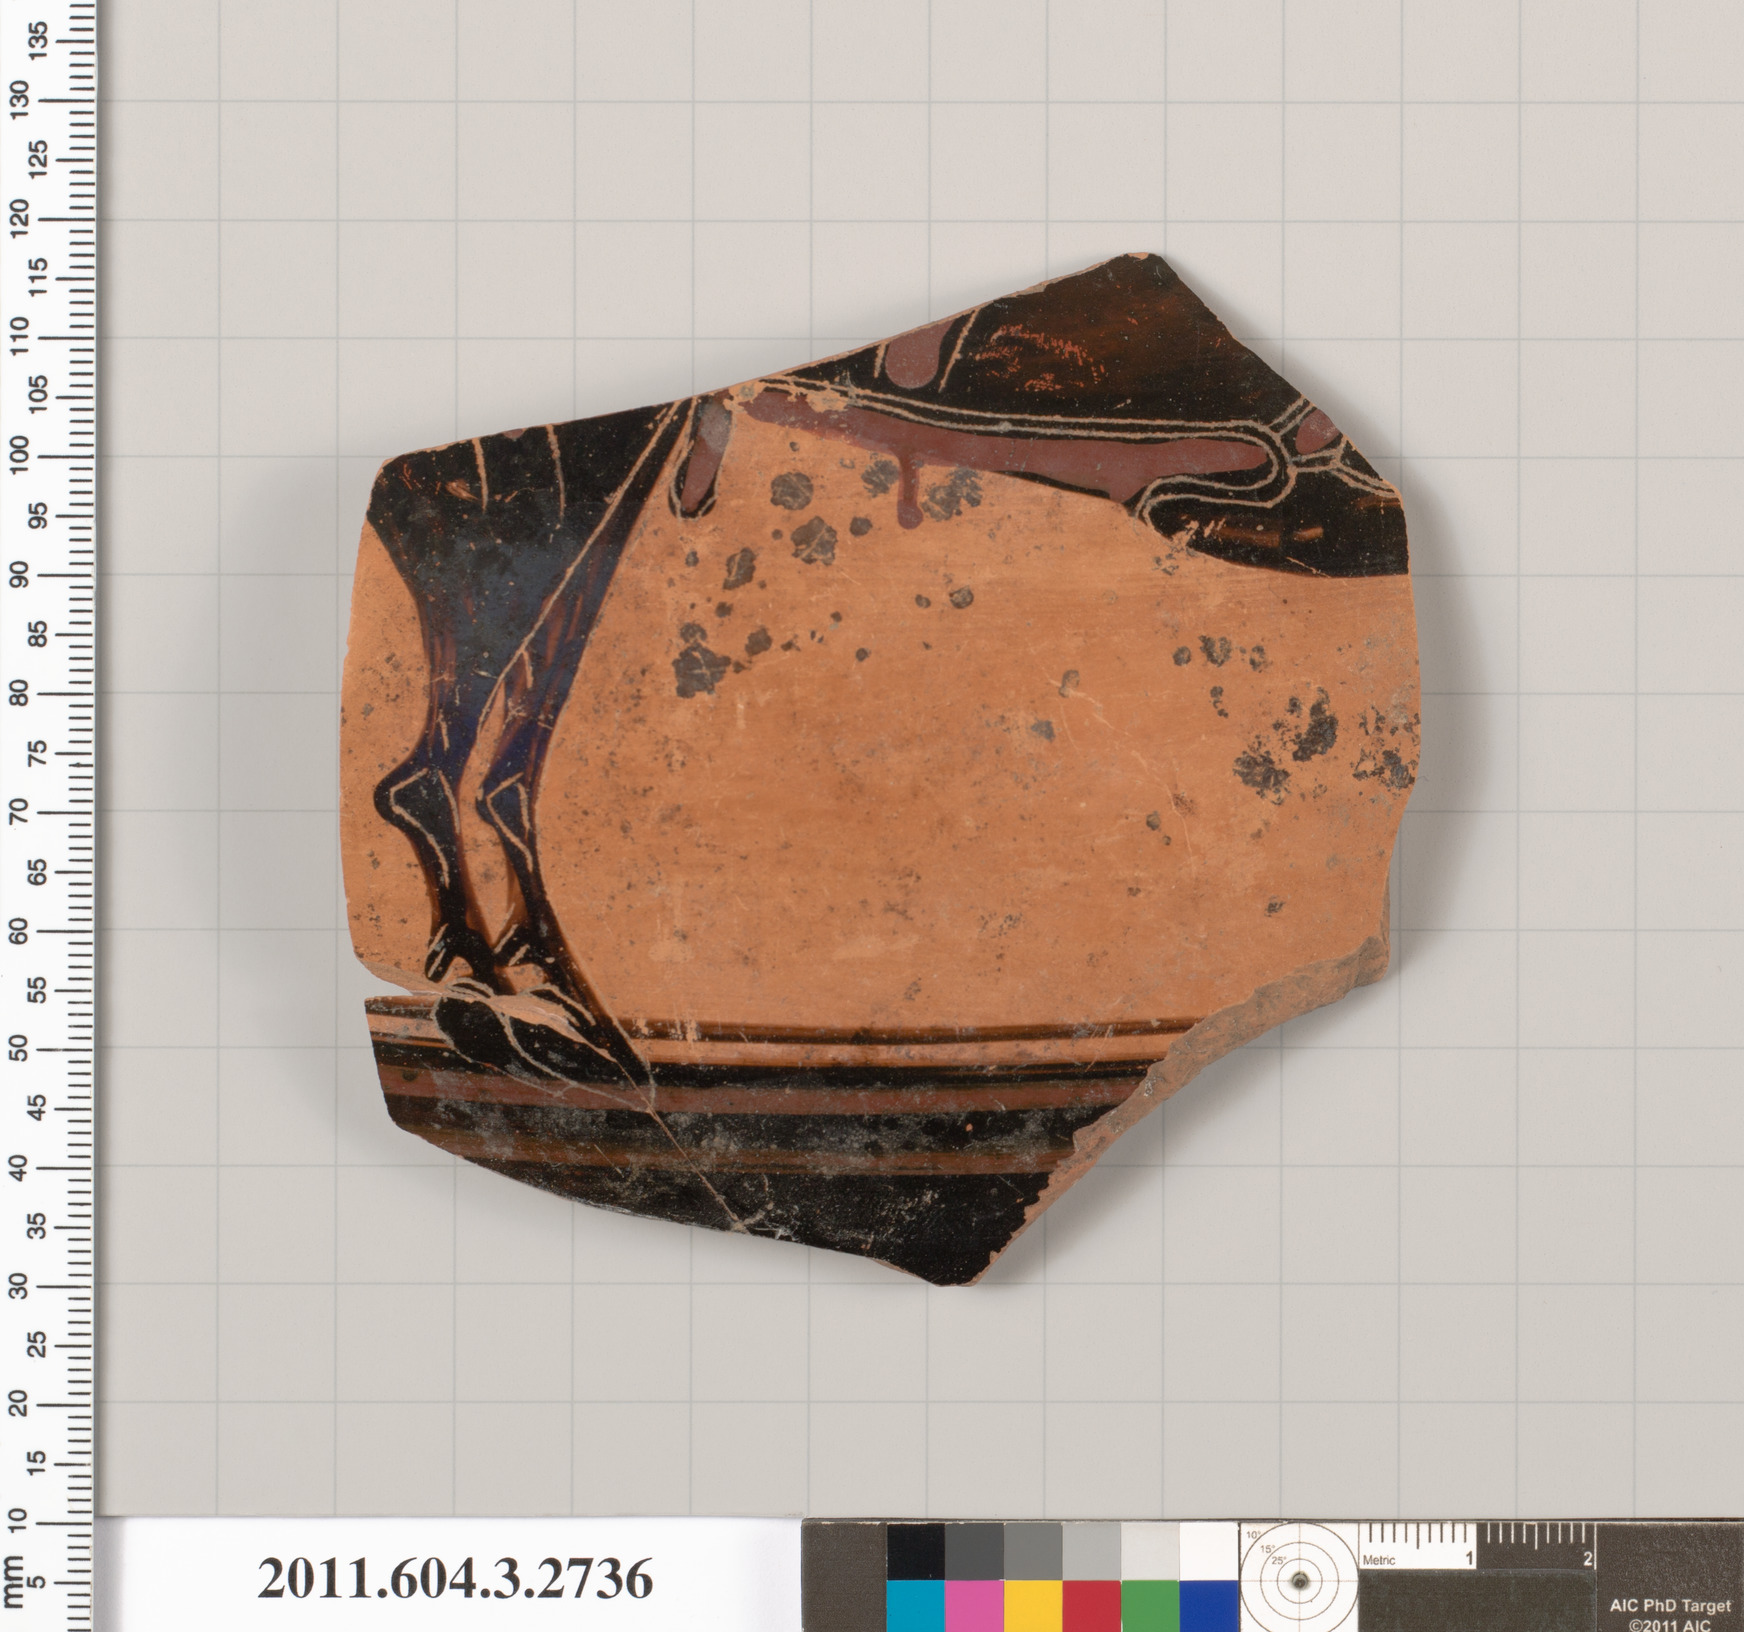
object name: olpe fragment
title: Terracotta fragment of a trefoil olpe (jug)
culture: greek, attic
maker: gorgon painter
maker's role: artist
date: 500-476 BCE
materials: terracotta